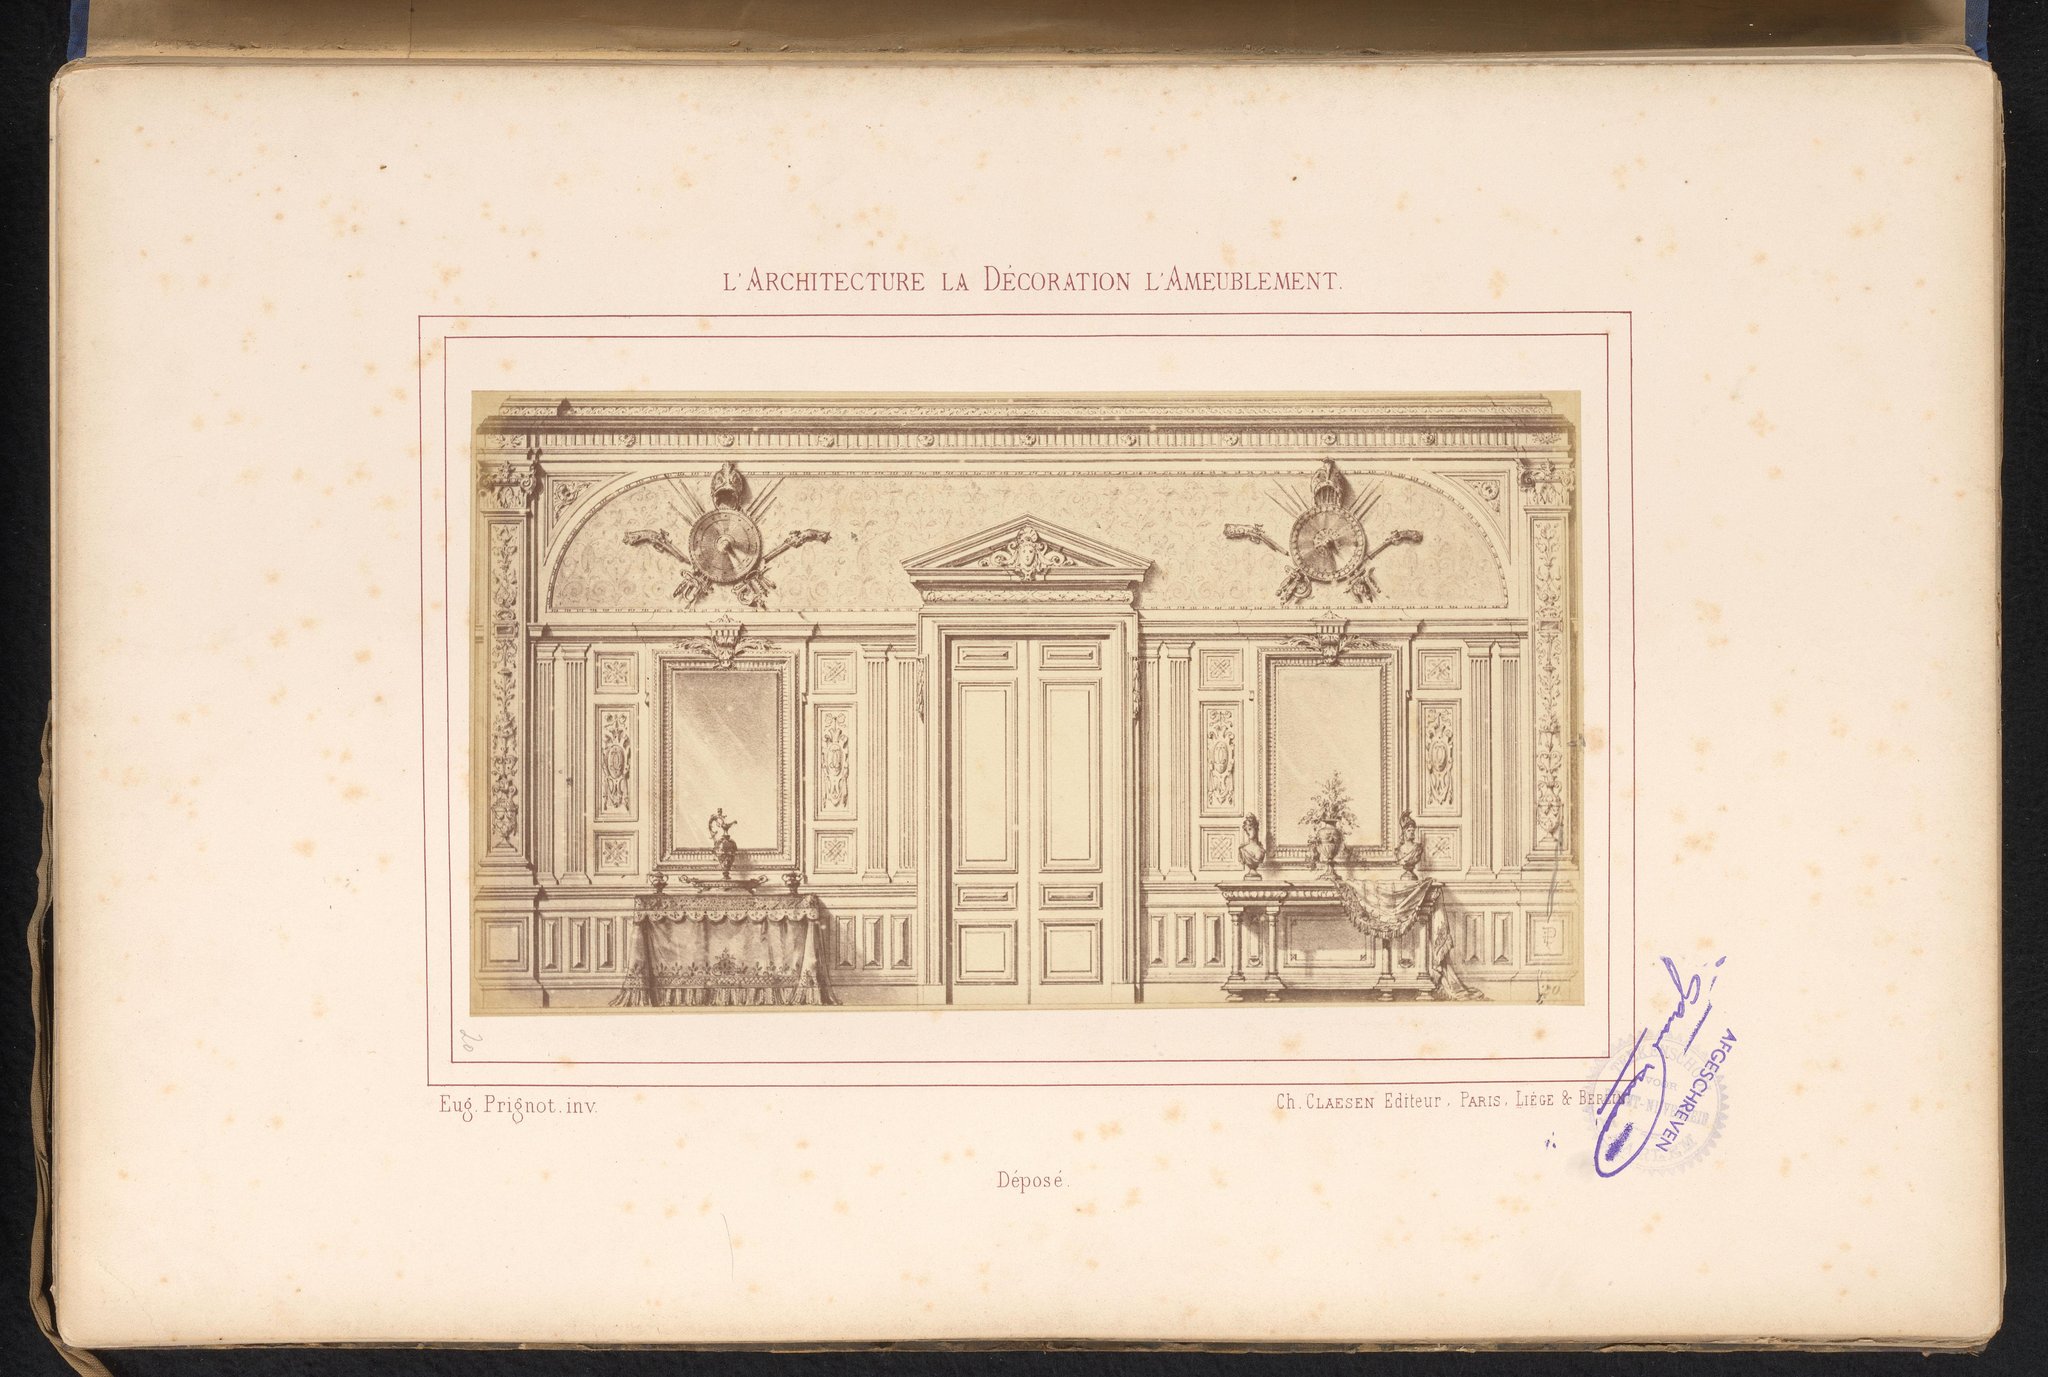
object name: photograph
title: L'Architecture la Décoration l'Ameublement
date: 1873-1880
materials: cardboard, paper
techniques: albumen print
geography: liège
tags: 'trionfi di tavola', 'pièces montées', mirror, door, wall-covering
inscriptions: inscription: ‘Déposé’, stamp: ‘AFGESCHREVEN/ [...]’, stamp: ‘TEEKENSCHOOL/ VOOR/ KUNST-NIJVERHEID/ HAARLEM’, number: ‘20’, inscription: ‘Eug. Prignot. inv.’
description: Deze foto maakt deel uit van een omslag met 61 foto's op 61 bladen.